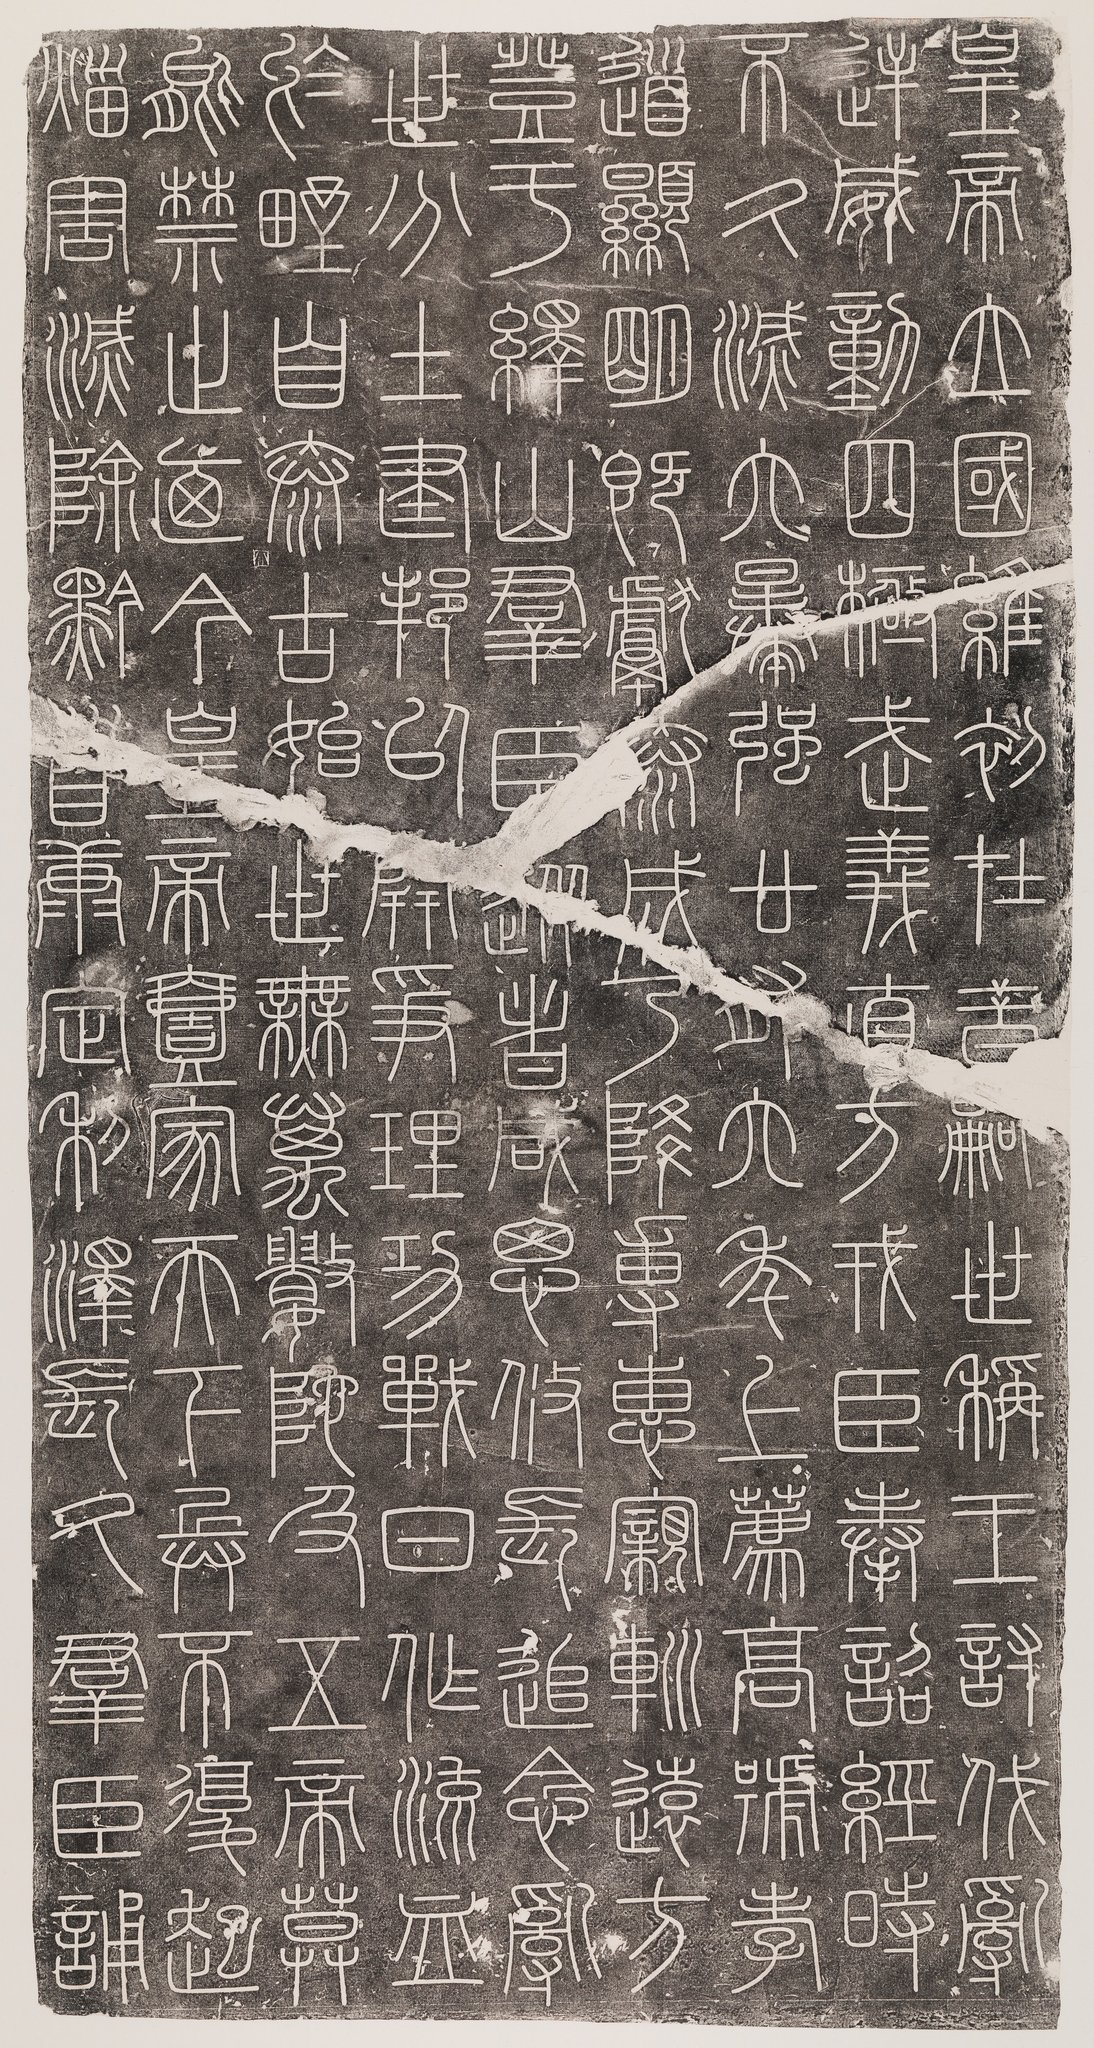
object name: rubbing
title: Inscriptions from the Stele of Mount Yi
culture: chinese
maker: xu xuan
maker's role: calligrapher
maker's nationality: chinese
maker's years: 916-991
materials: ink, paper